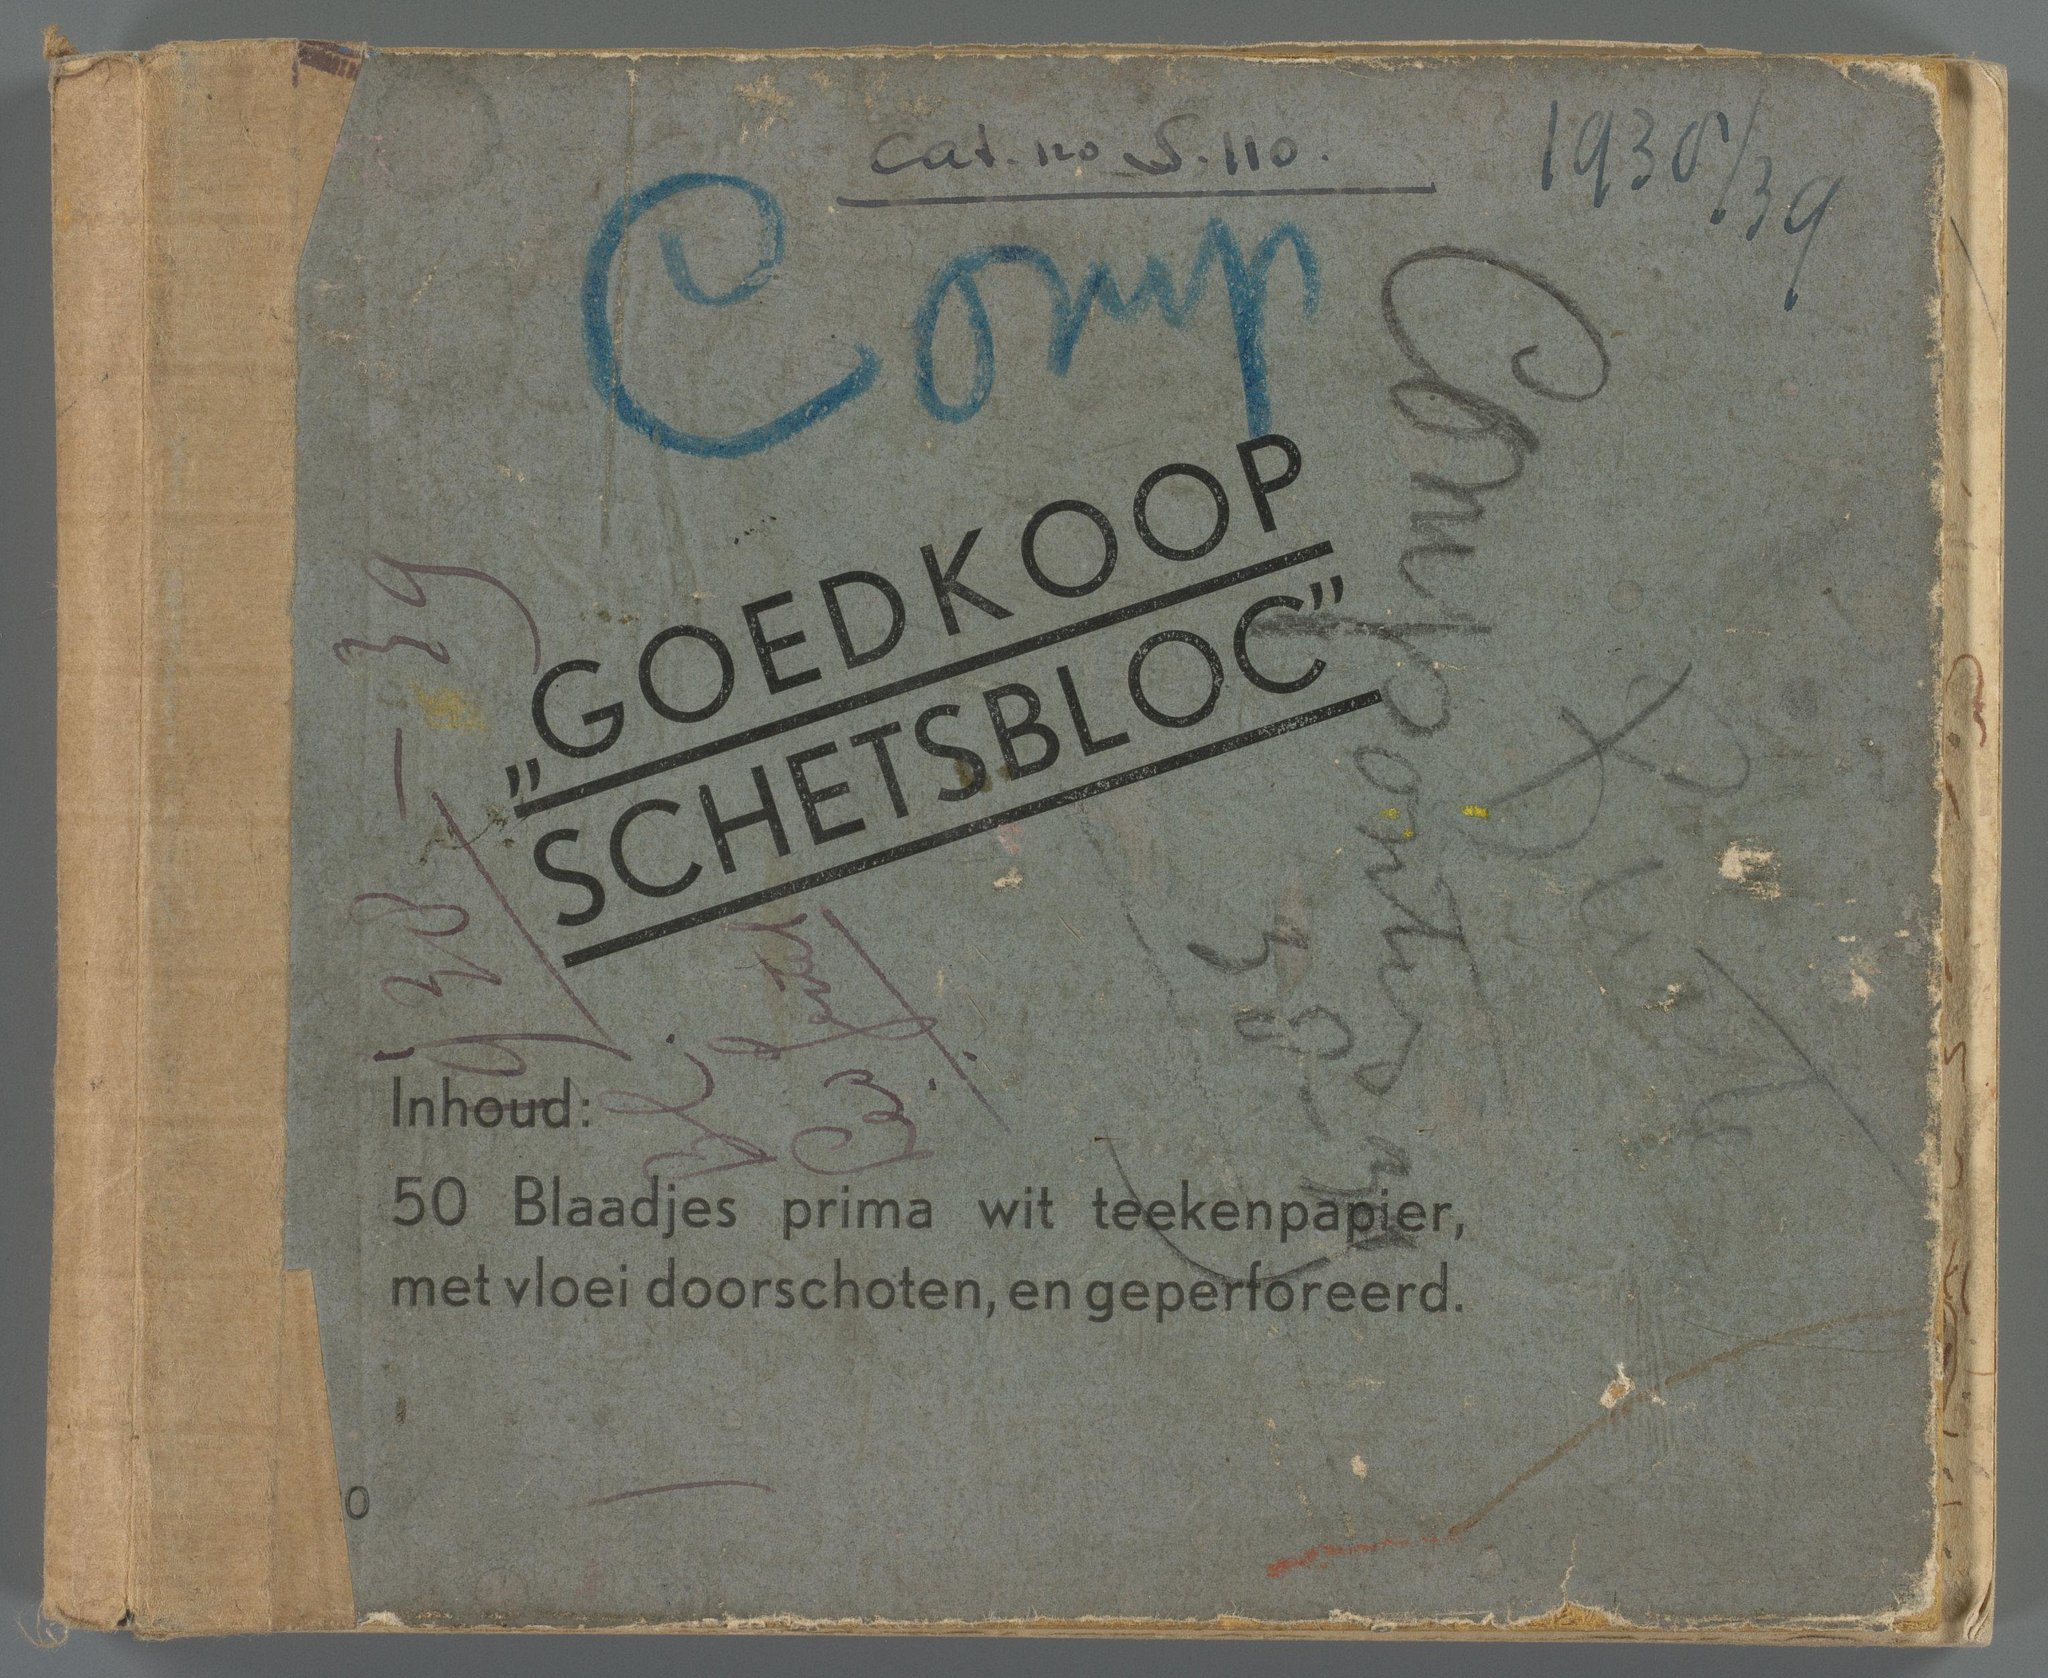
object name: sketchbook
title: Schetsboek Blaricum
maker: leo gestel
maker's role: draughtsman, print maker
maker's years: 1881-1941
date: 1938-1939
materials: chalk, ink, paper, pencil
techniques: brush, drawing, pen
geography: blaricum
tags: meadow, pasture, horse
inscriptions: inscription: ‘natuurkrabbels’, workshop stamp: Lugt 1078a, signature, date and inscription: ‘1938-39 Bl Leo Gestel/ Composities 38-39’, inscription: ‘schetsboek 1938-1939/ 47 tekeningen/ compositie schetsen’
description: Schetsboek met studies van weidelandschap, vee, paarden, composities en een vrouwelijk naakt.